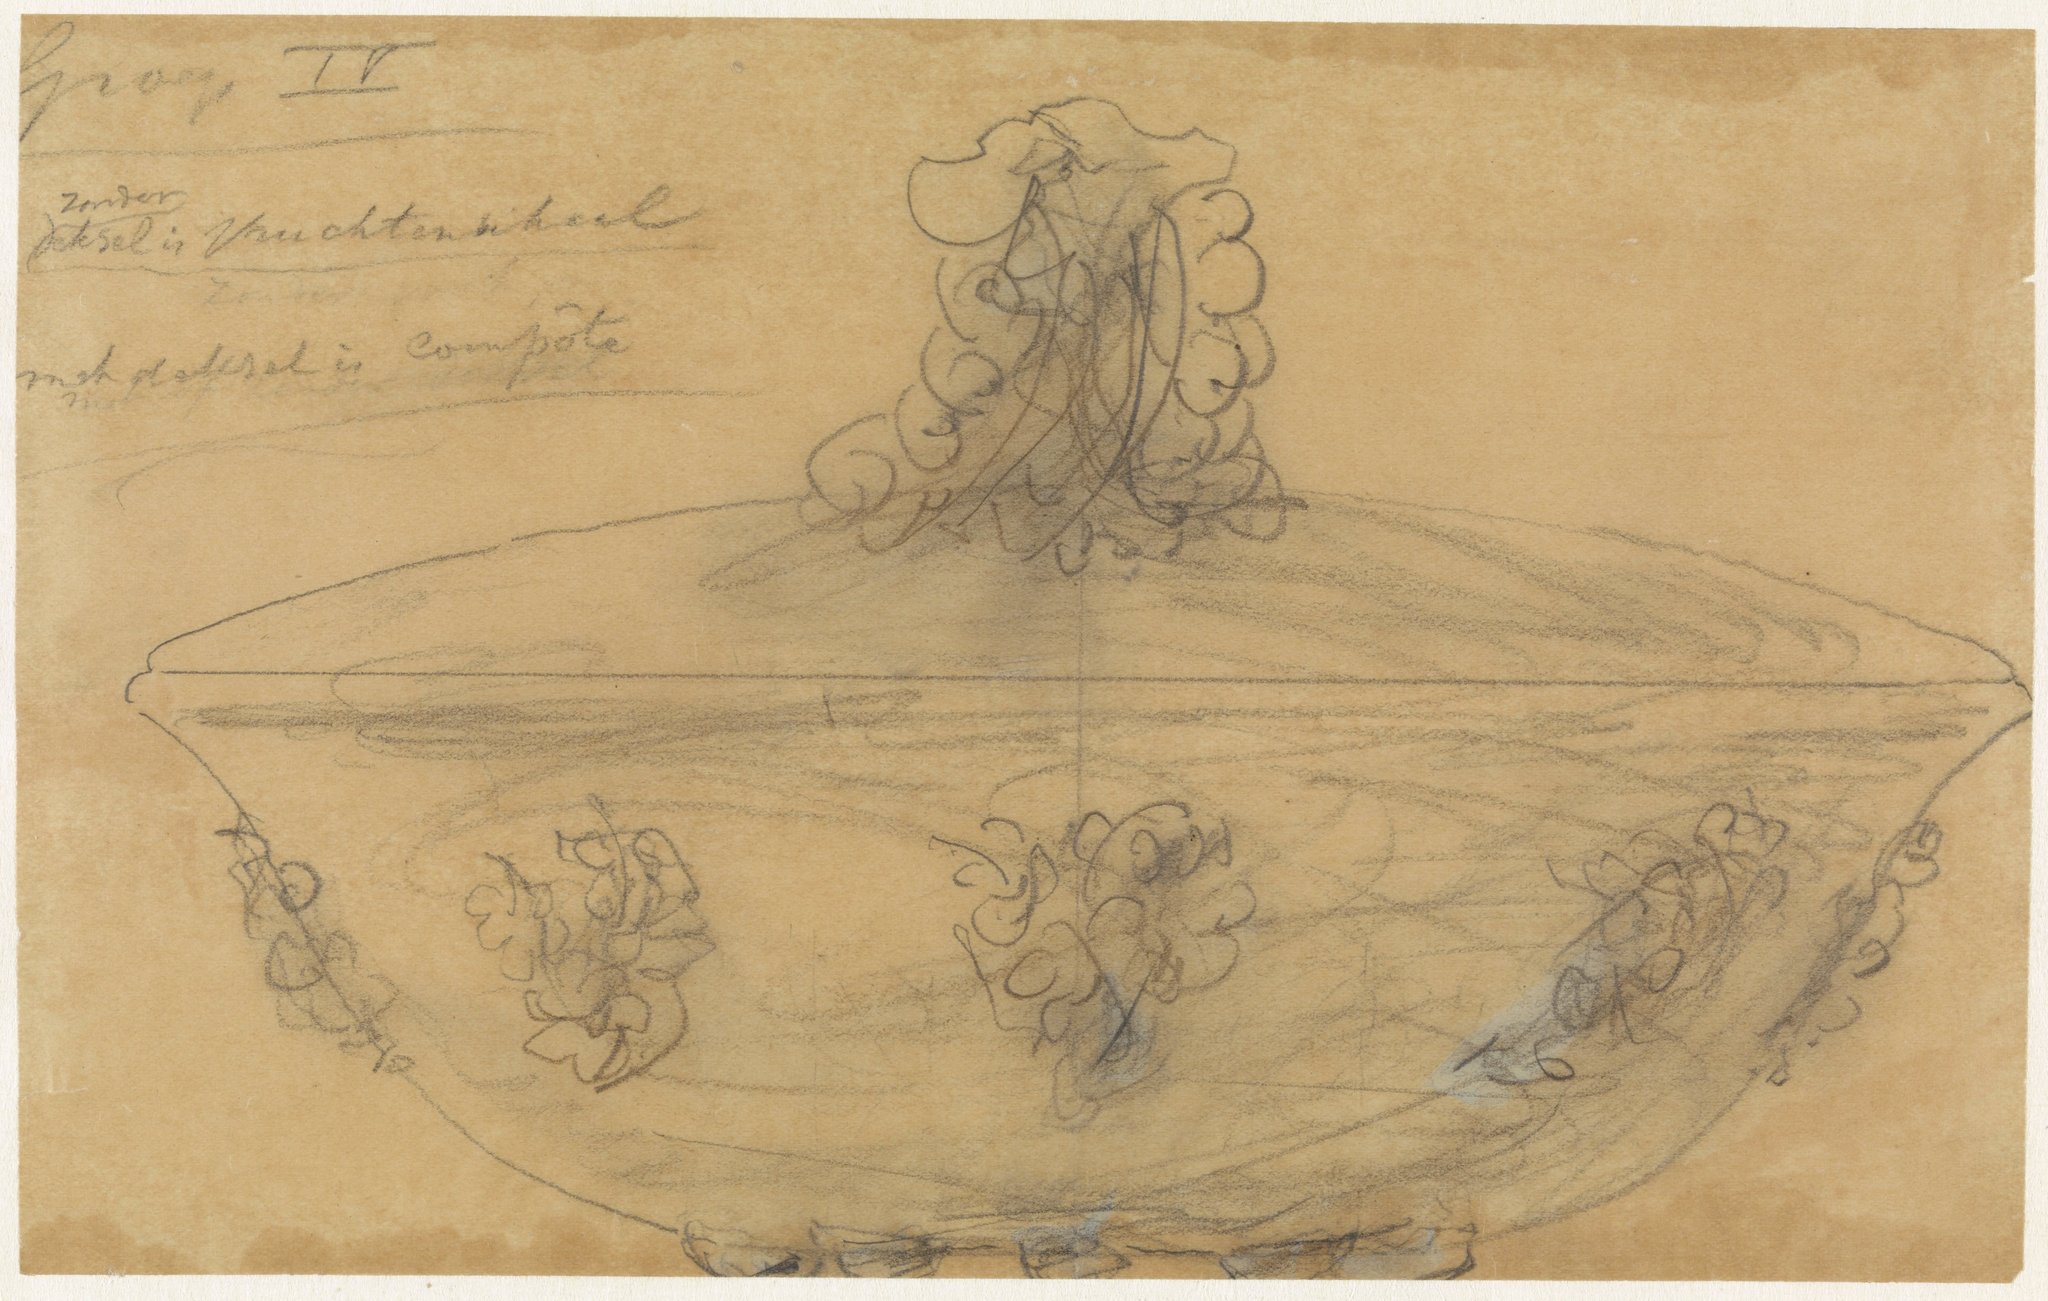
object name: drawing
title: Ontwerp voor een vruchten- en compoteschaal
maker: theo colenbrander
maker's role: draughtsman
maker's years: 1841-1930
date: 1851-1930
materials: pencil, paper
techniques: brush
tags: bowl